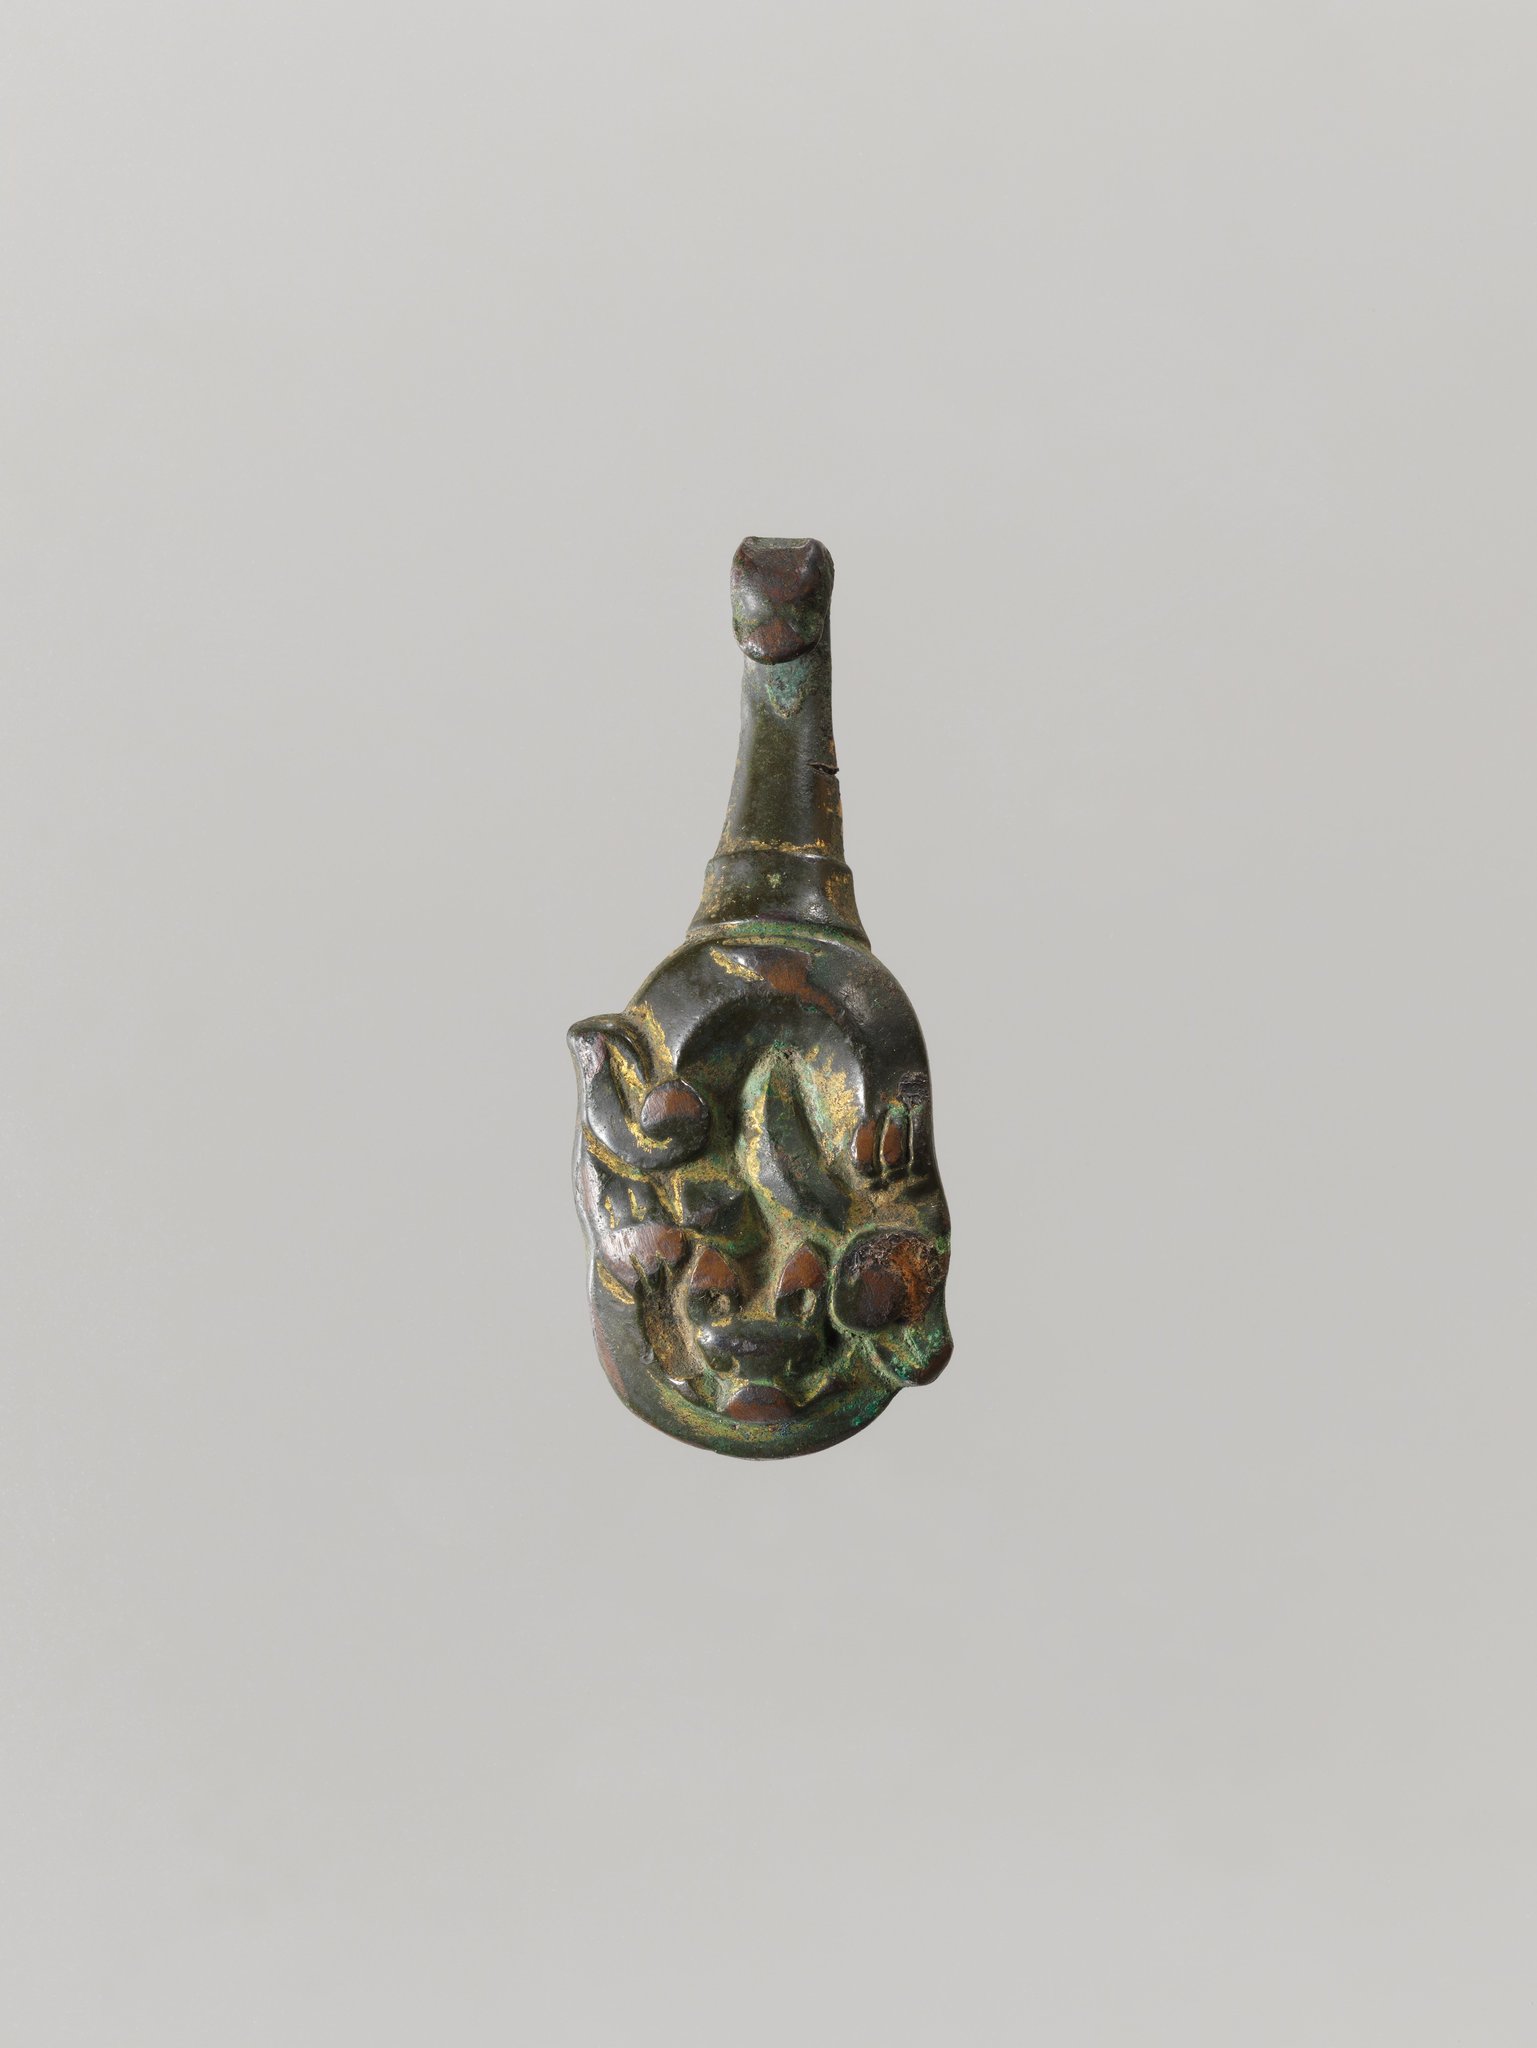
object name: belt hook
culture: chinese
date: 1046-256 BCE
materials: bronze